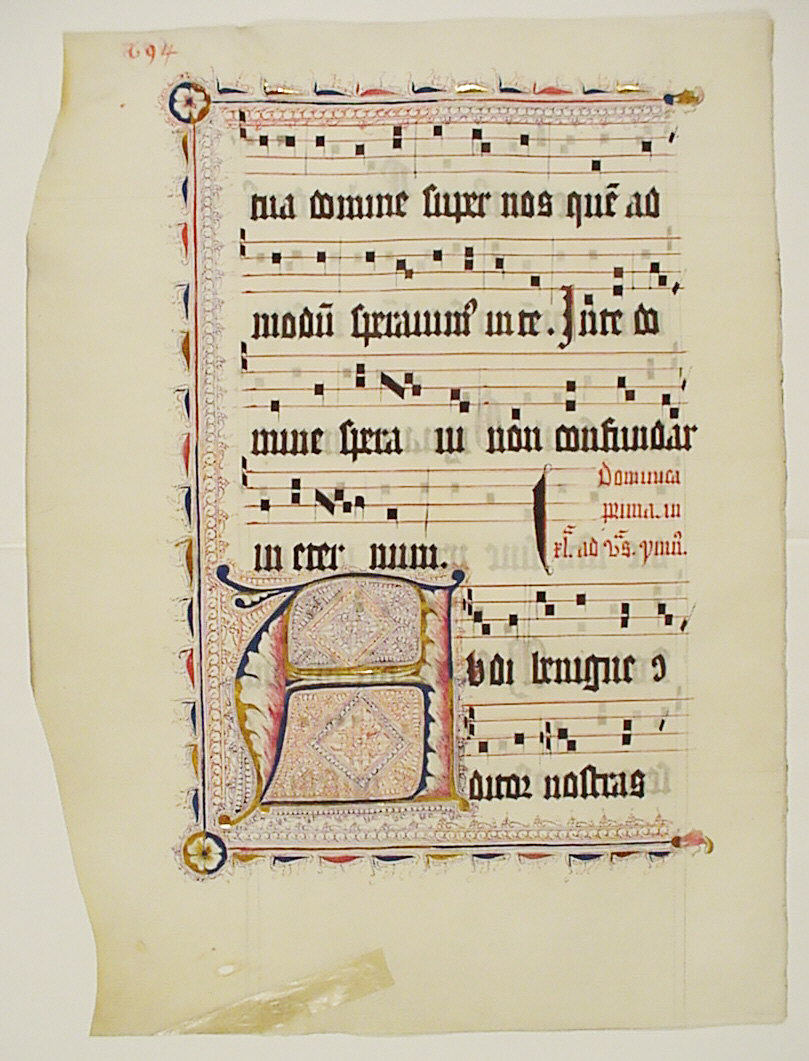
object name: antiphonary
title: Manuscript Leaf with Initial A, from an Antiphonary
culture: german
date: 1426-1450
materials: ink, metal leaf, parchment, paint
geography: germany